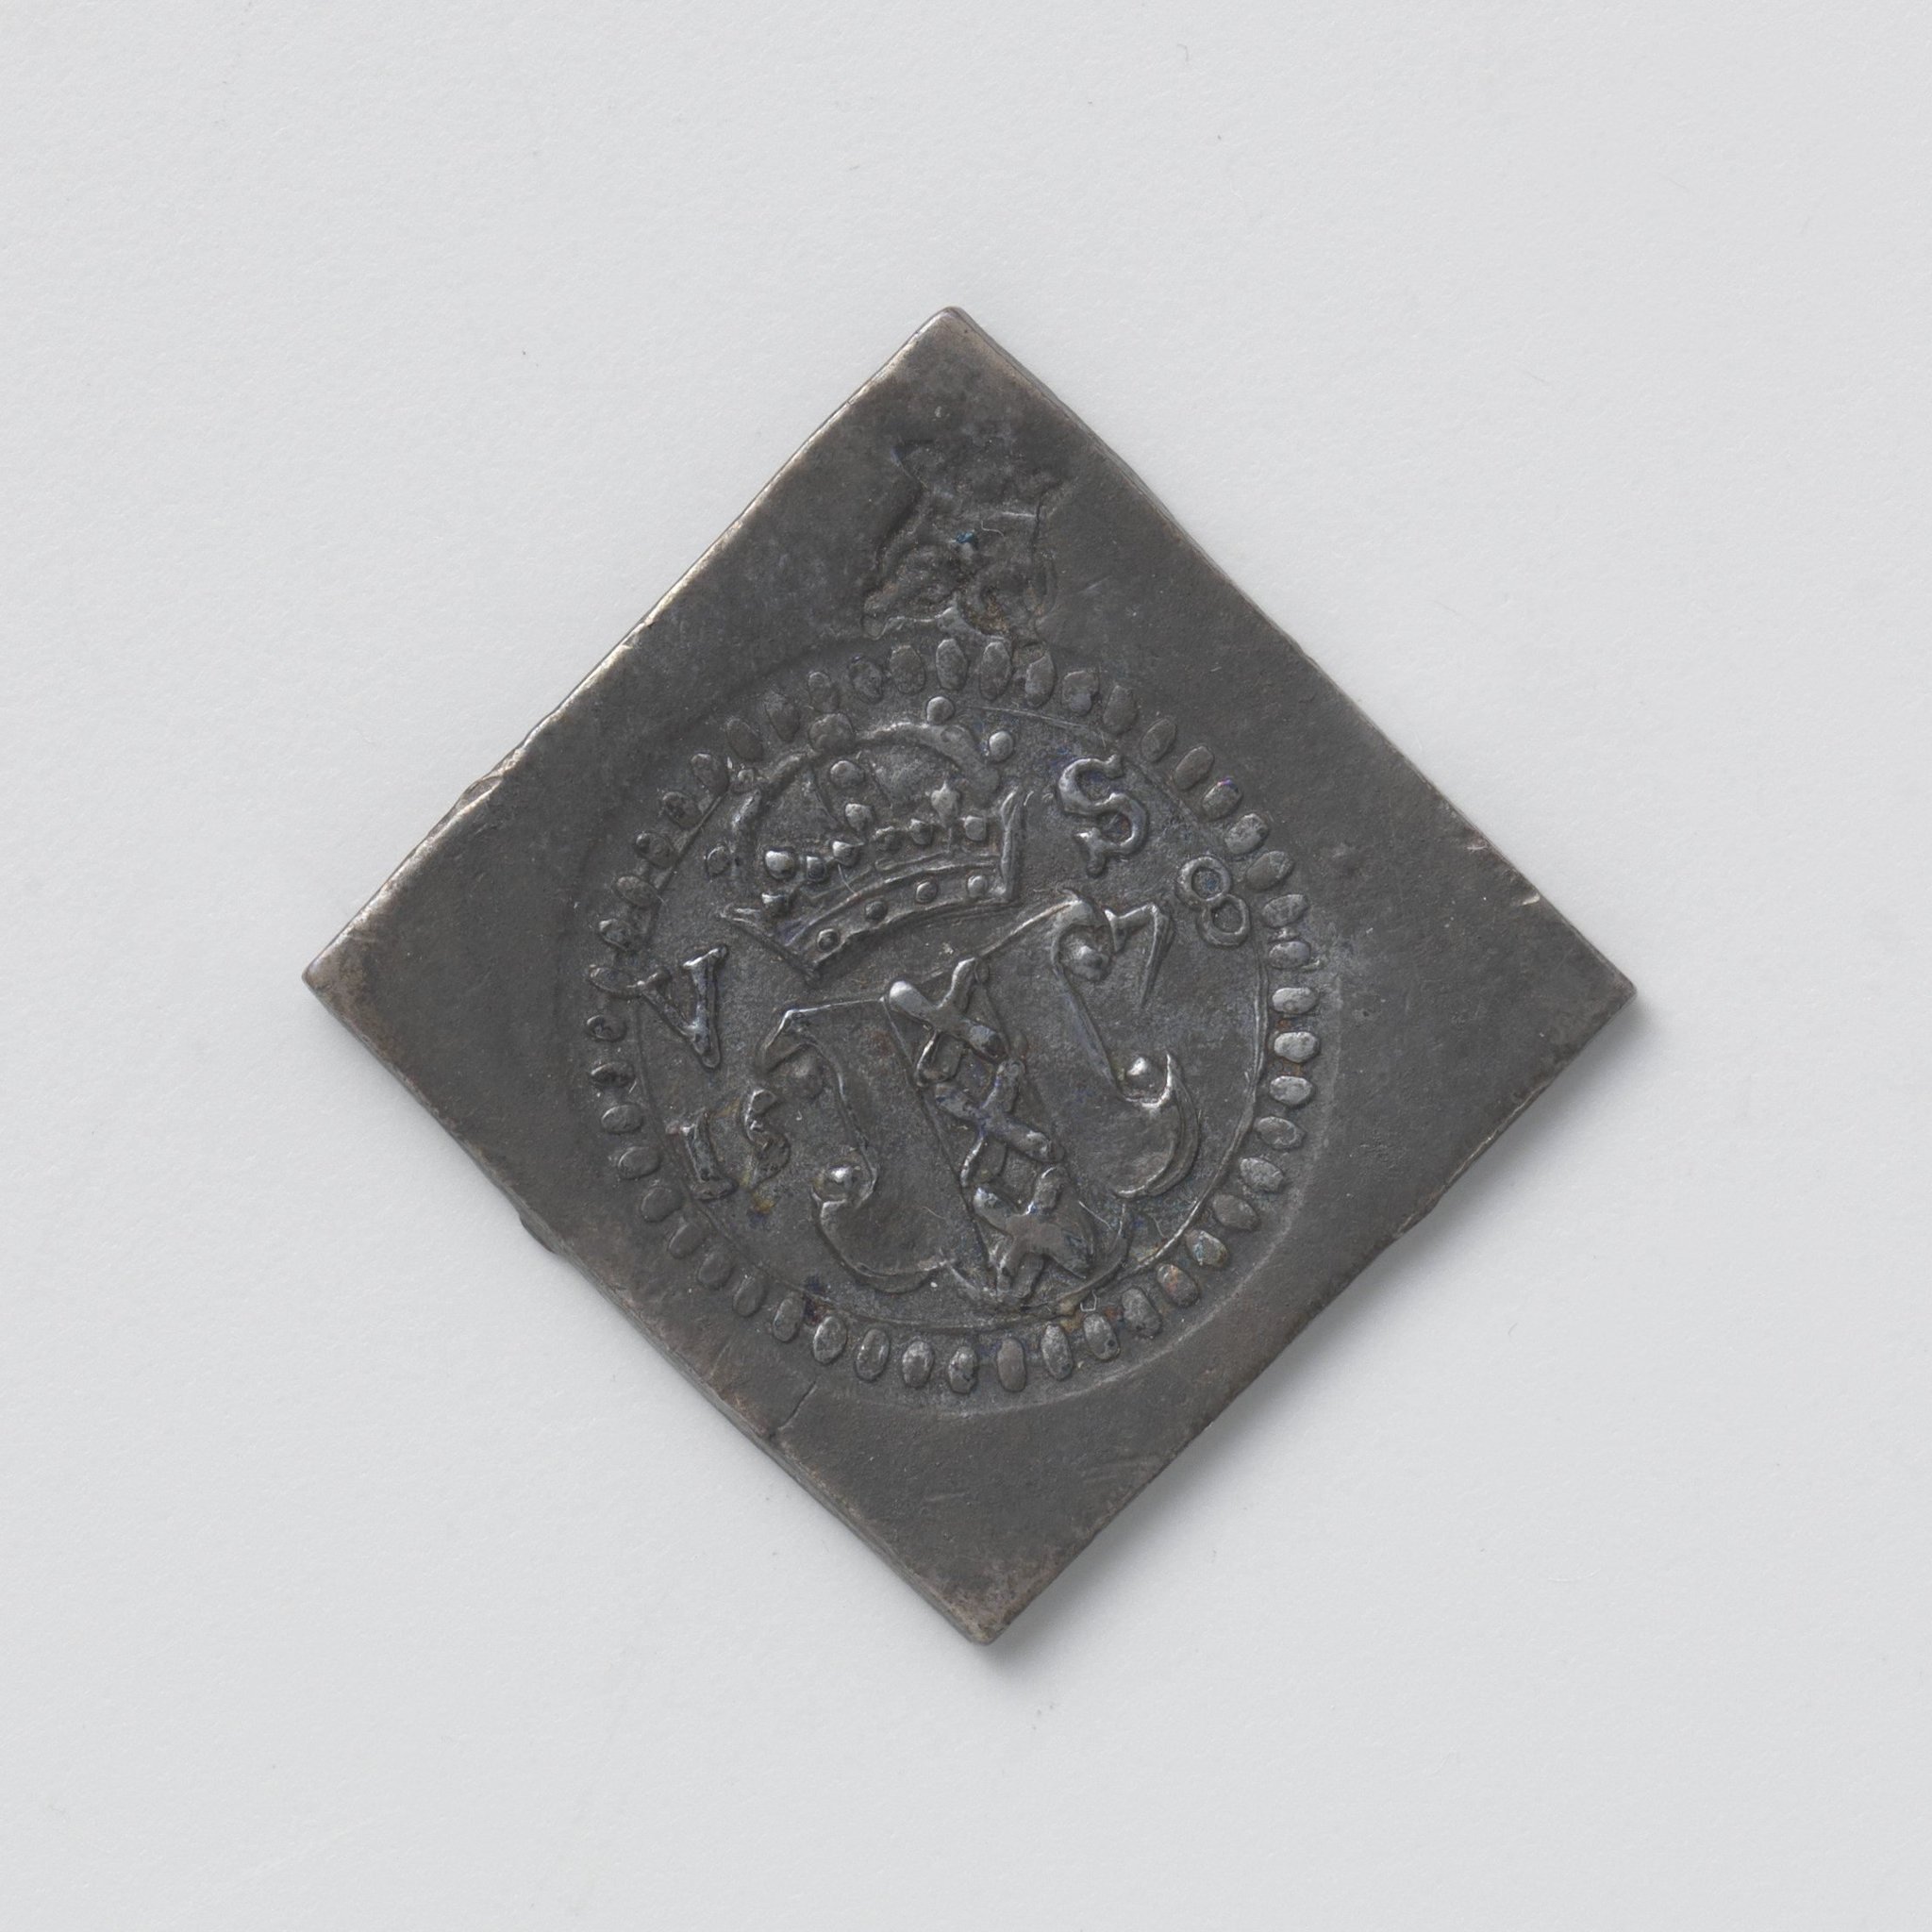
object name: siege coin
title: Vijf stuiver, noodmunt uit Amsterdam, geslagen tijdens het beleg uit het stedelijke zilver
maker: Anonymous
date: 1578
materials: silver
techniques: striking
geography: amsterdam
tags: amsterdam